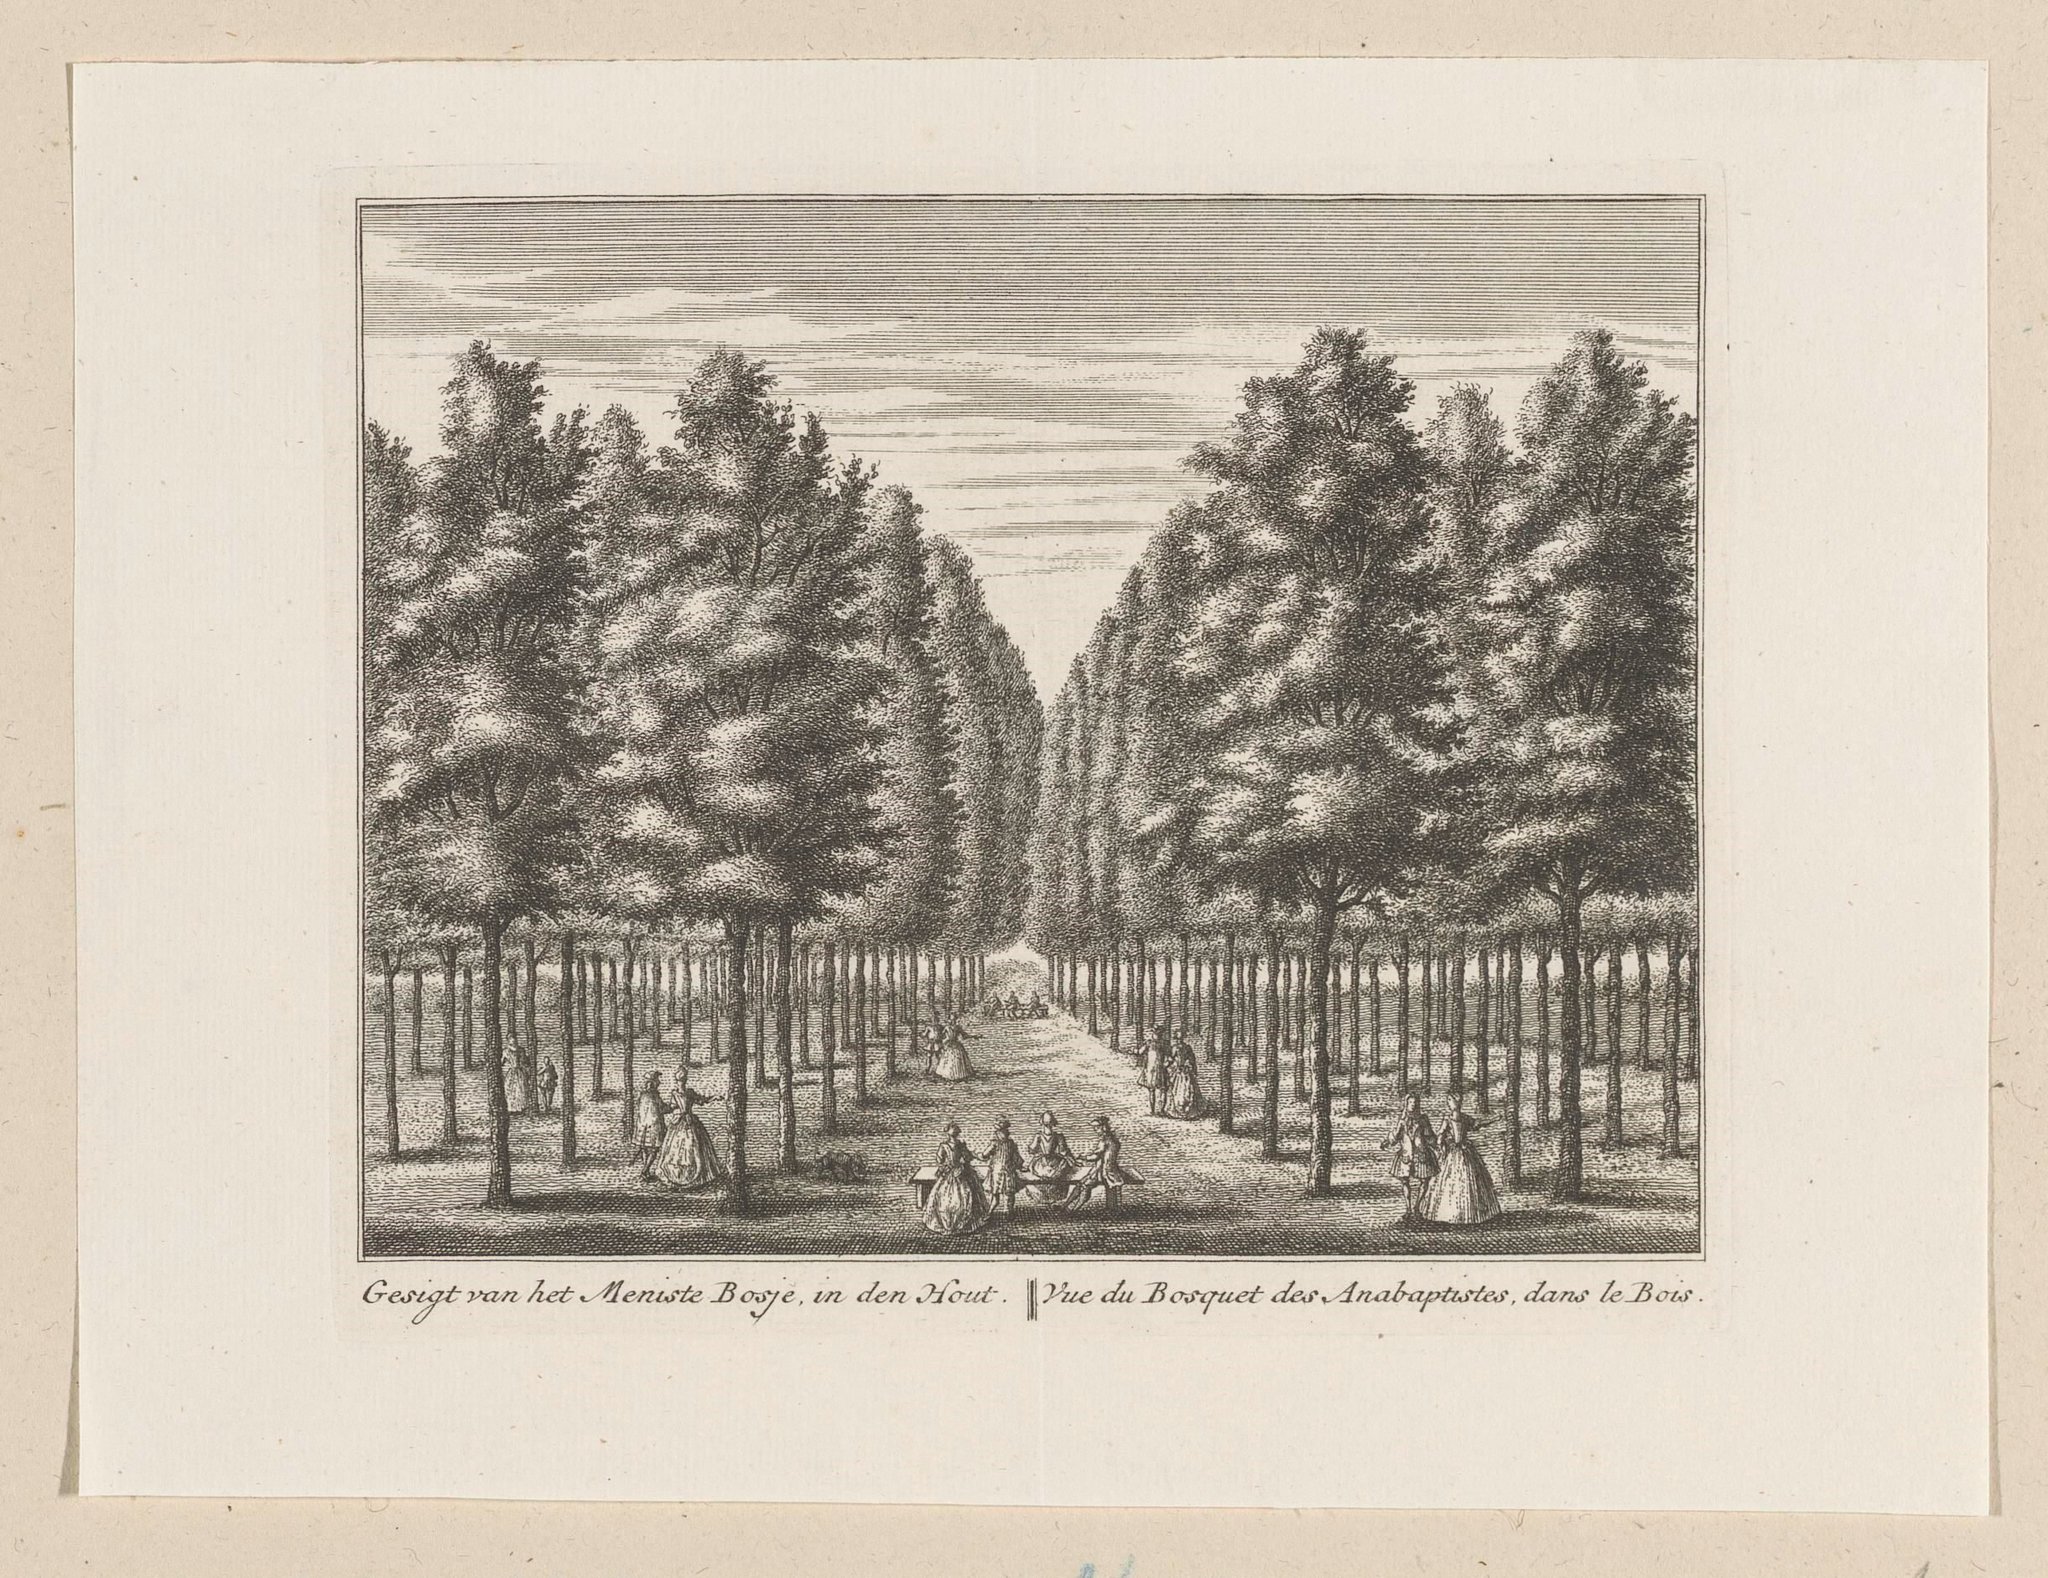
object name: print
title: Alle de voornaamste gesigten van de stadt Alckmaar geleegen in West-Vriesland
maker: leonard schenk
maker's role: print maker, publisher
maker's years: 1696-1767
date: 1736-1746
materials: paper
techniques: etching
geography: northern netherlands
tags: forest path or lane (+ landscape with figures, staffage)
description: Als onderdeel van een prentserie van gezichten op Alkmaar in een publicatie met drie prentseries van stadsgezichten (op Alkmaar, Delft en Dordrecht) is deze prent ook gebruikt in: Rademaker, Abraham. Alle de voornaamste gesigten van de wydberoemde steeden Alkmaar, Delft en Dordregt (...) / Toutes les principales vuës de la fameuse villes d'Alcmar, Delft & Dordregt (…). Amsterdam: Leonard Schenk, 1736. Als illustratie is deze prent ook gebruikt in: Woude, C. van der. Kronyck van Alckmaar. Met zyn dorpen (…). 2e druk. Amsterdam: Steven van Esveldt, 1743. En in: Woude, C. van der. Kronyck van Alckmaar. Met zyn dorpen (…). 2e druk. Den Haag: Johannes de Cros, 1746. Uit welke druk het huidige exemplaar precies komt is niet na te gaan.